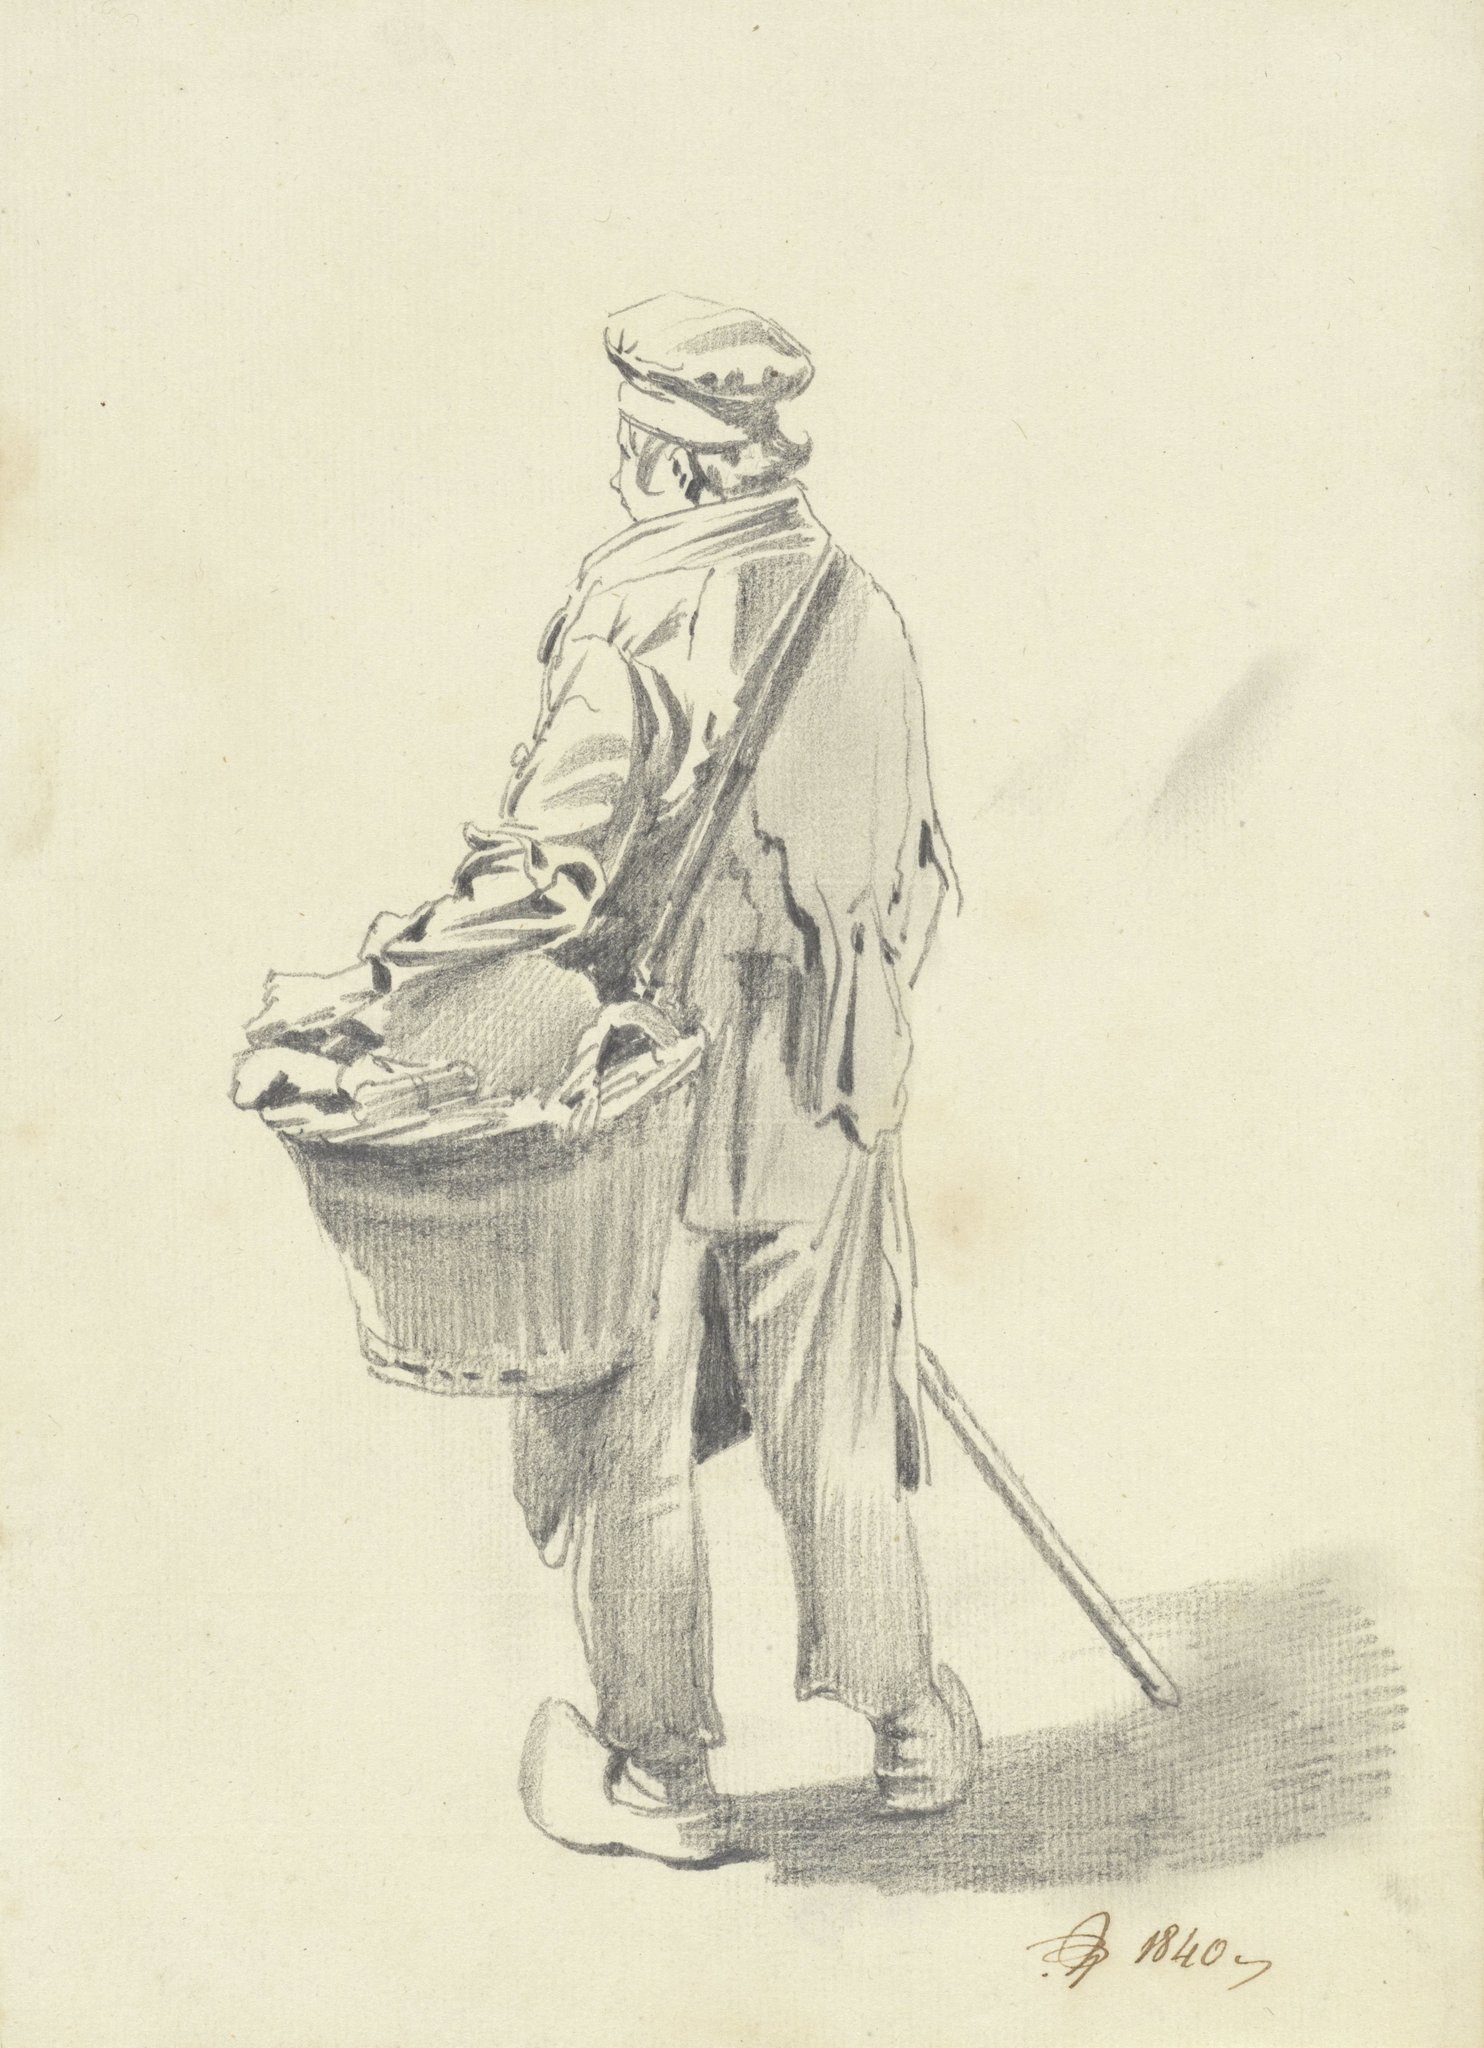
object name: drawing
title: Voddenboer, van achteren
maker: pieter van loon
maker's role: draughtsman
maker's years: 1801-1873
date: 1840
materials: paper, pencil